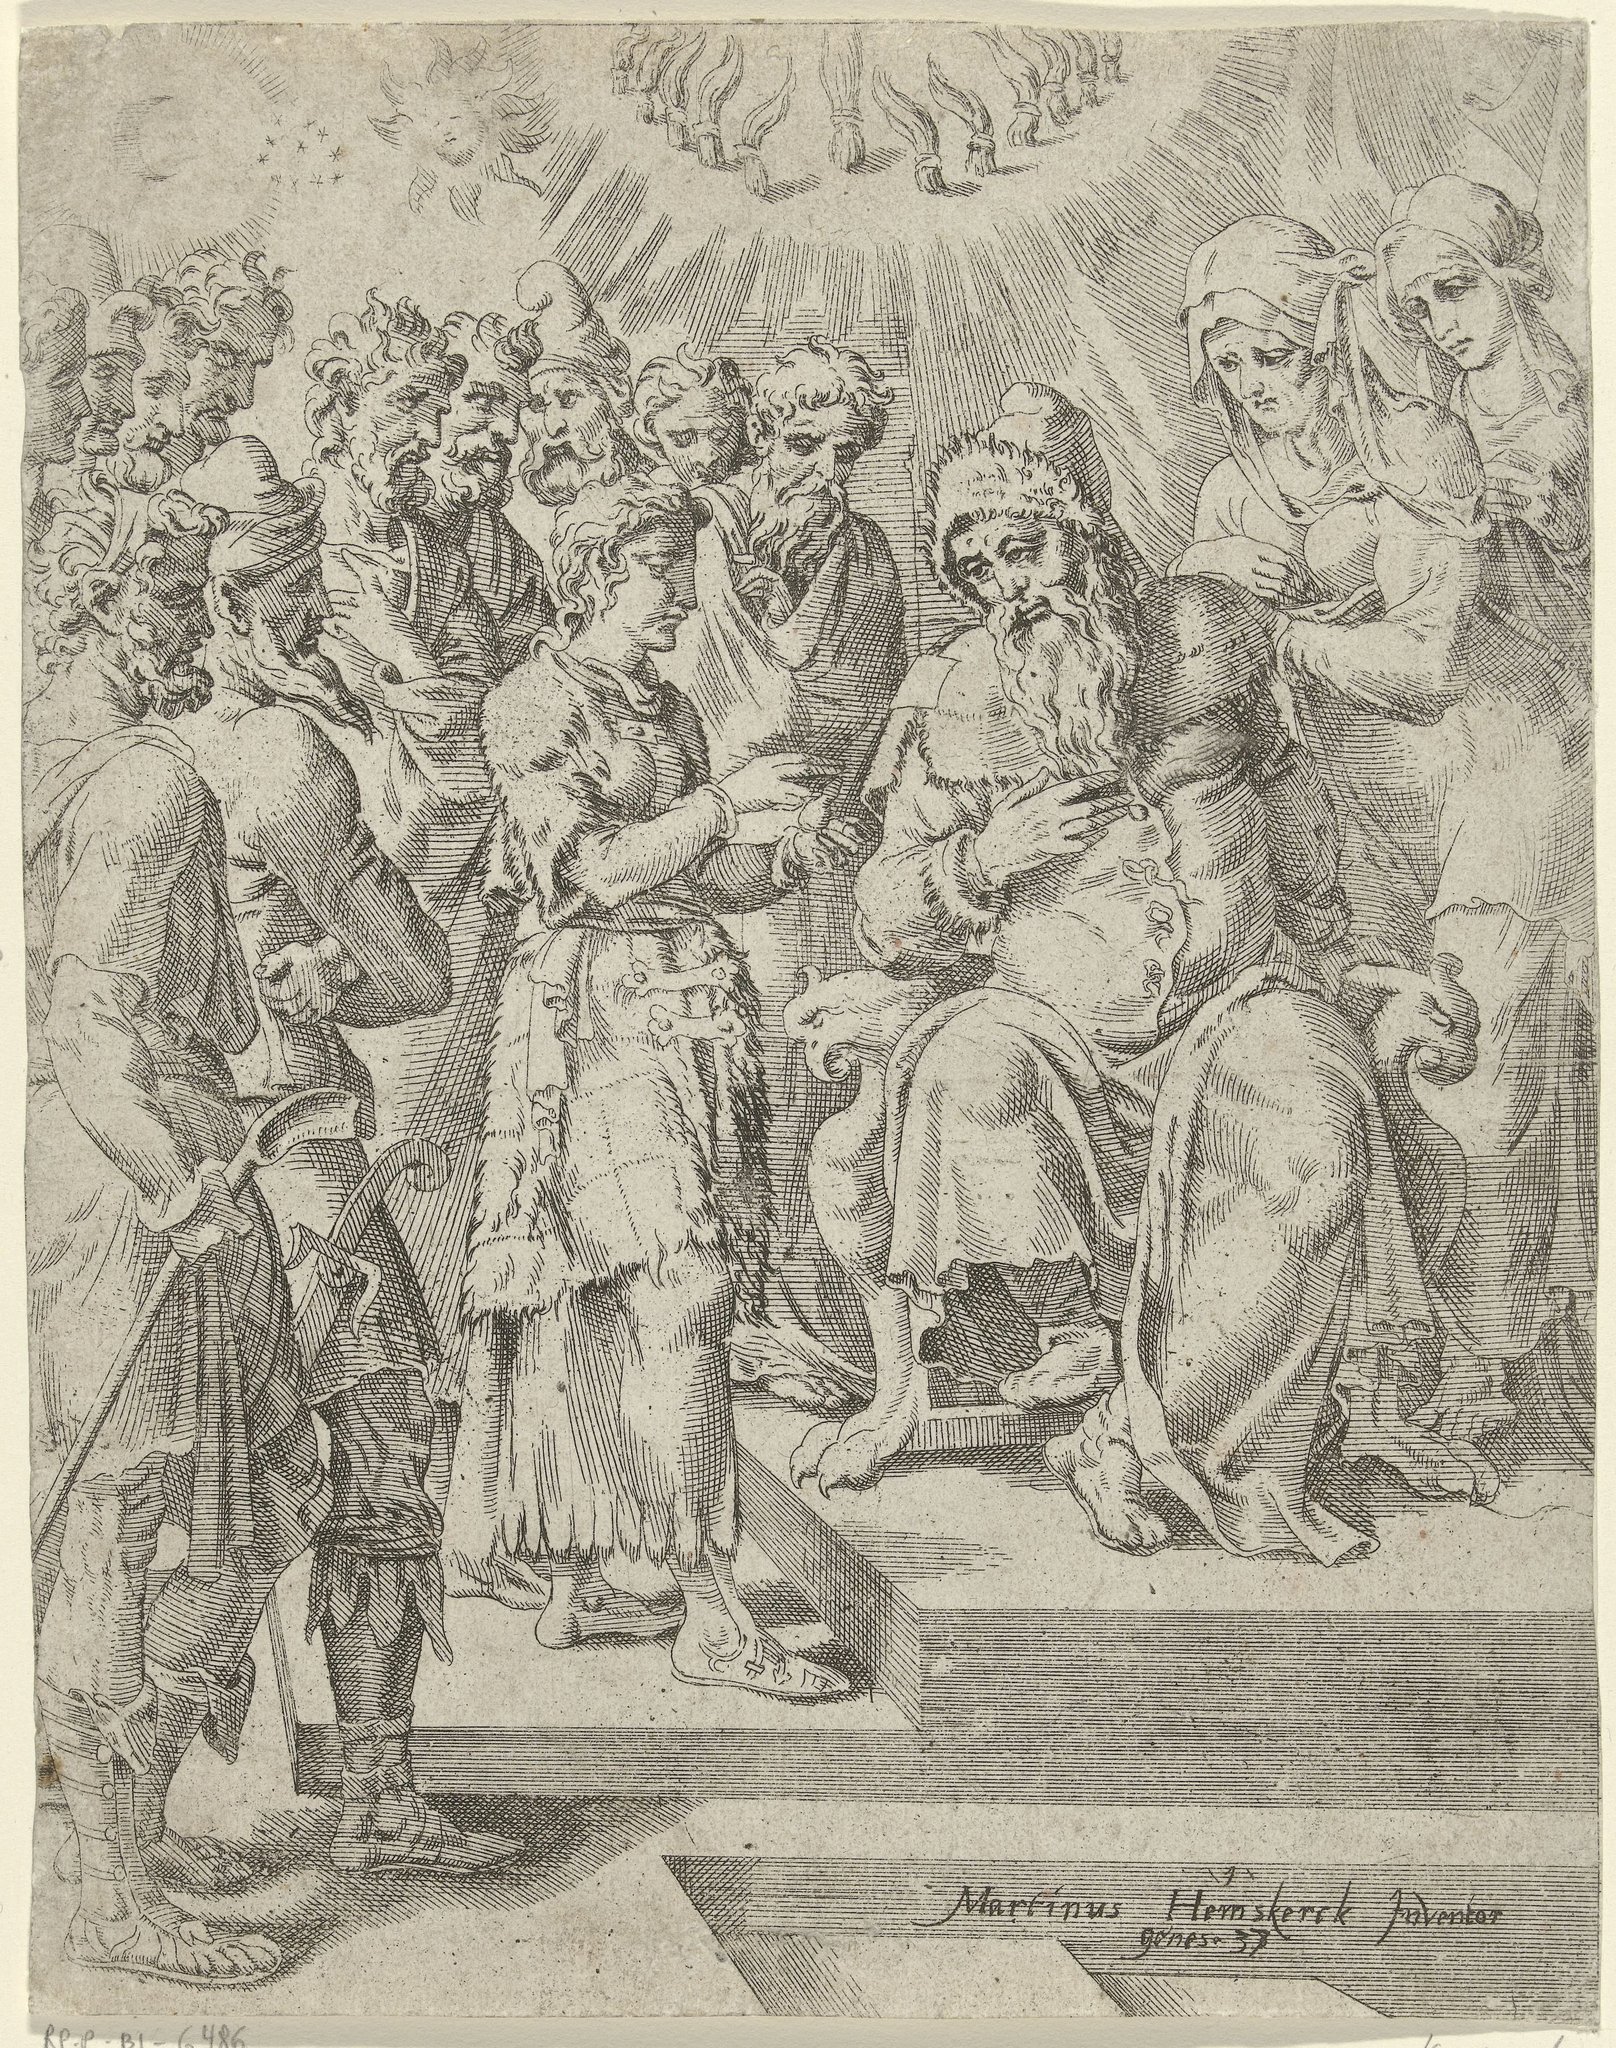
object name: print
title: Jozef vertelt zijn dromen aan zijn vader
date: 1549-1550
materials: paper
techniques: etching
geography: haarlem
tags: joseph relating his dreams (the two dreams combined)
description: Jozef vertelt zijn vader en zijn broers over dromen die hij heeft gehad. Een droom toont de elf graanschoven van zijn broers die buigen voor de graanschoof van Jozef. De andere droom toont hoe de zon. de maan en de sterren voor Jozef buigen. De prent maakt deel uit van een serie over de geschiedenis van Jozef.